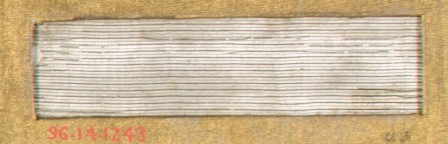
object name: piece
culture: japanese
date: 1701-1900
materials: silk